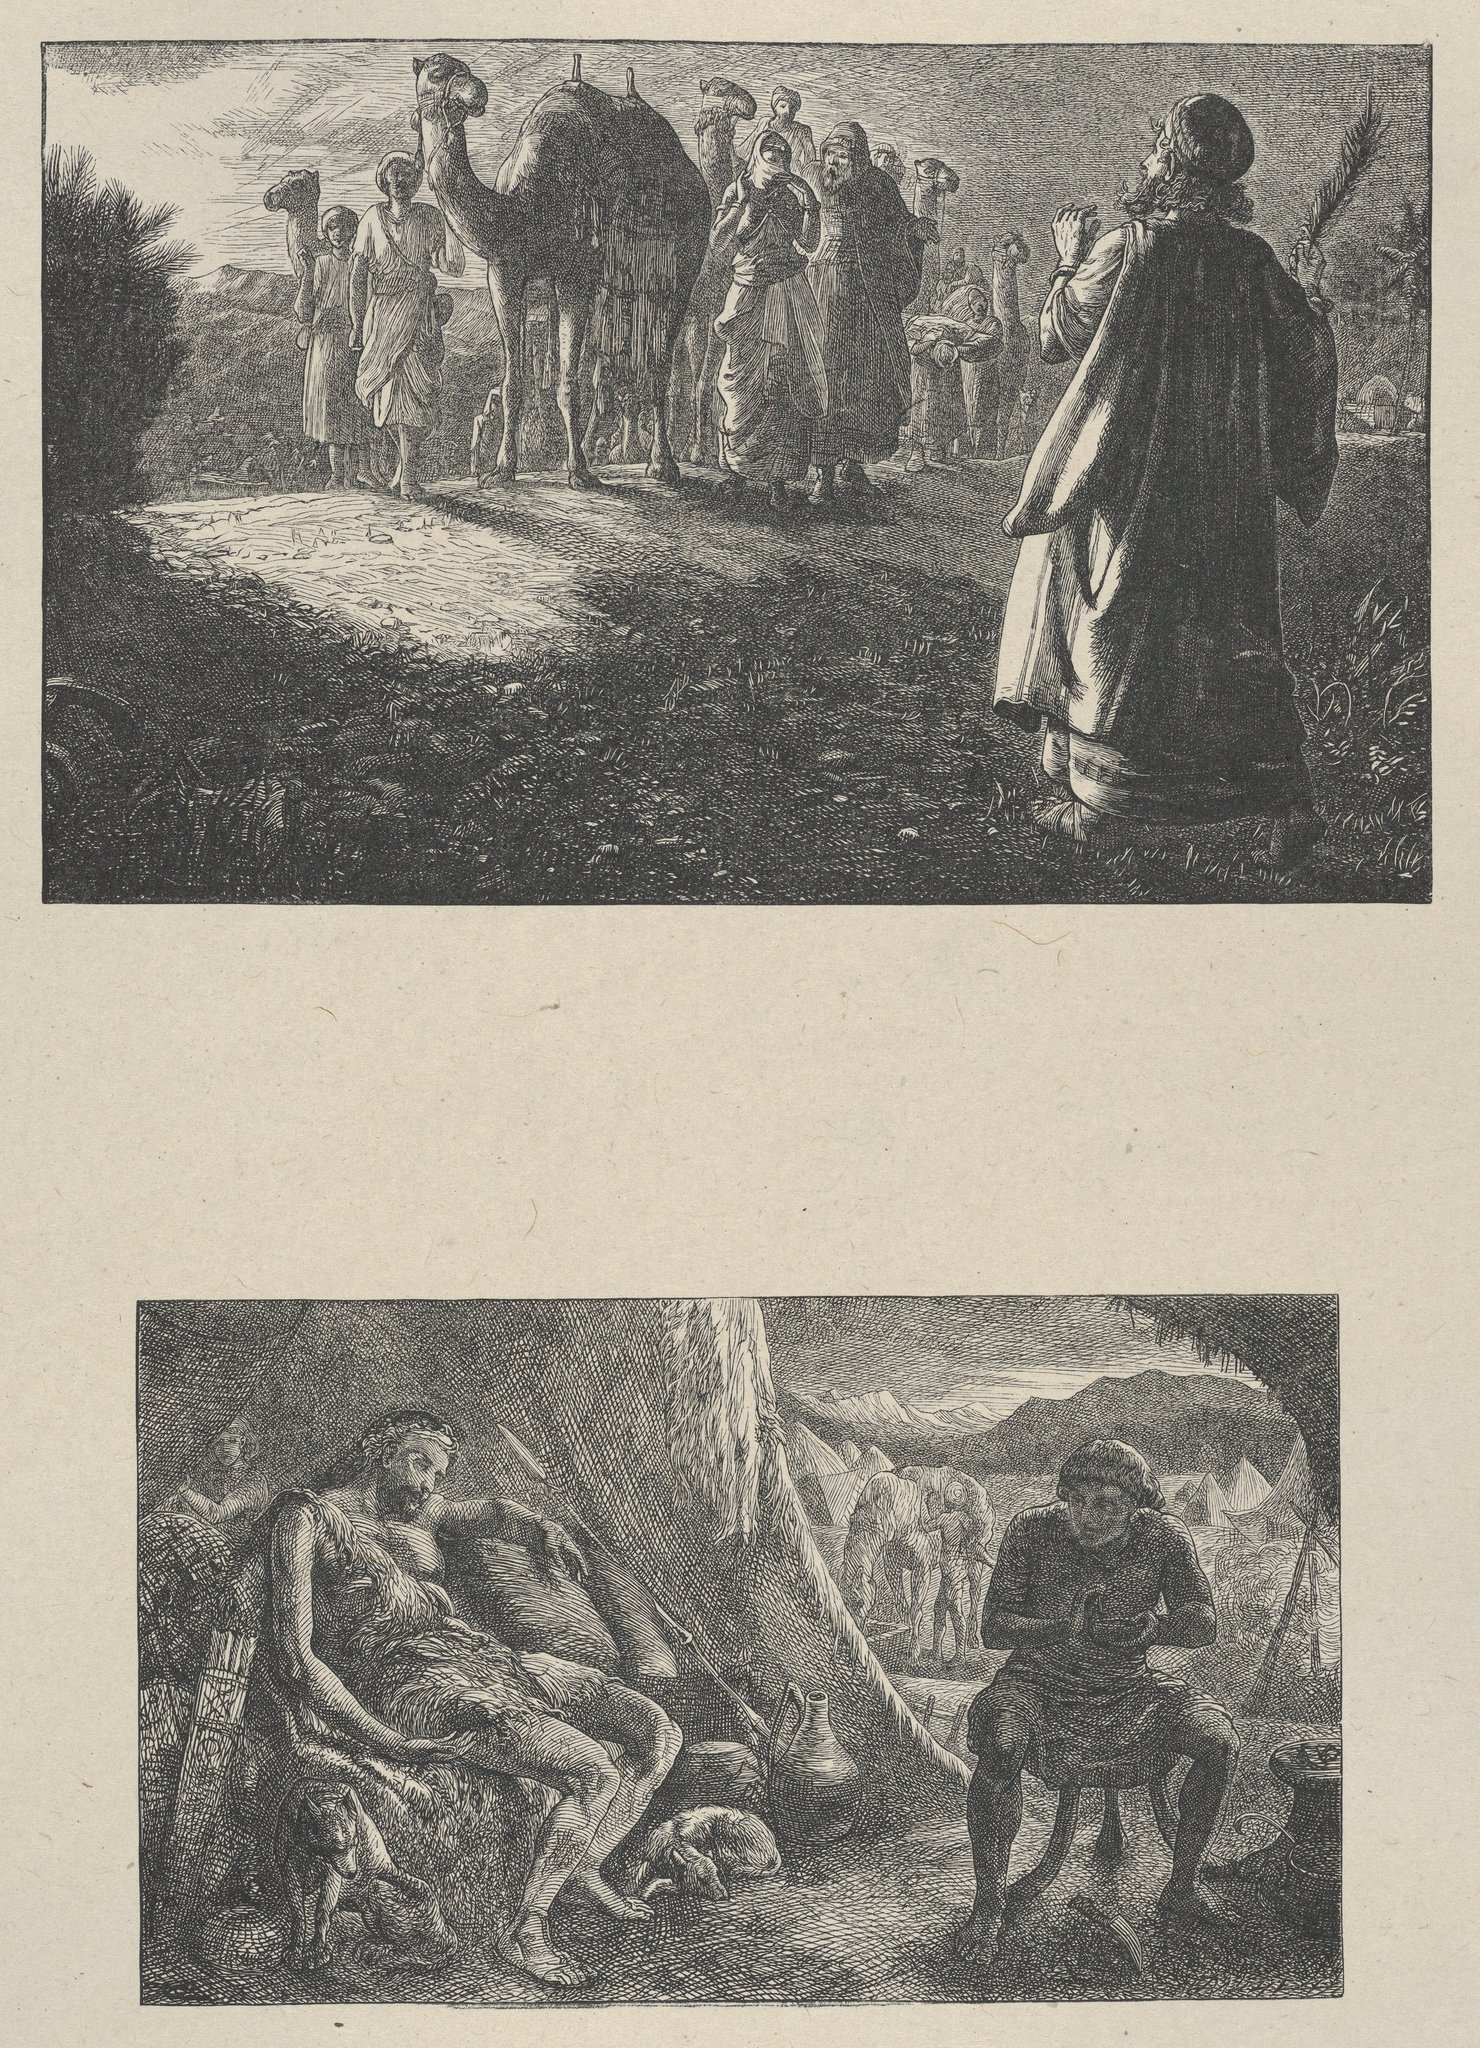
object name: print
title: Isaac Meeting Rebekah–Esau Selling His Birthright, from "Dalziels' Bible Gallery"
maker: thomas dalziel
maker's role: artist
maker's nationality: british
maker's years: 1823-1906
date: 1865-1881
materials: paper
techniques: engraving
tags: men,camels